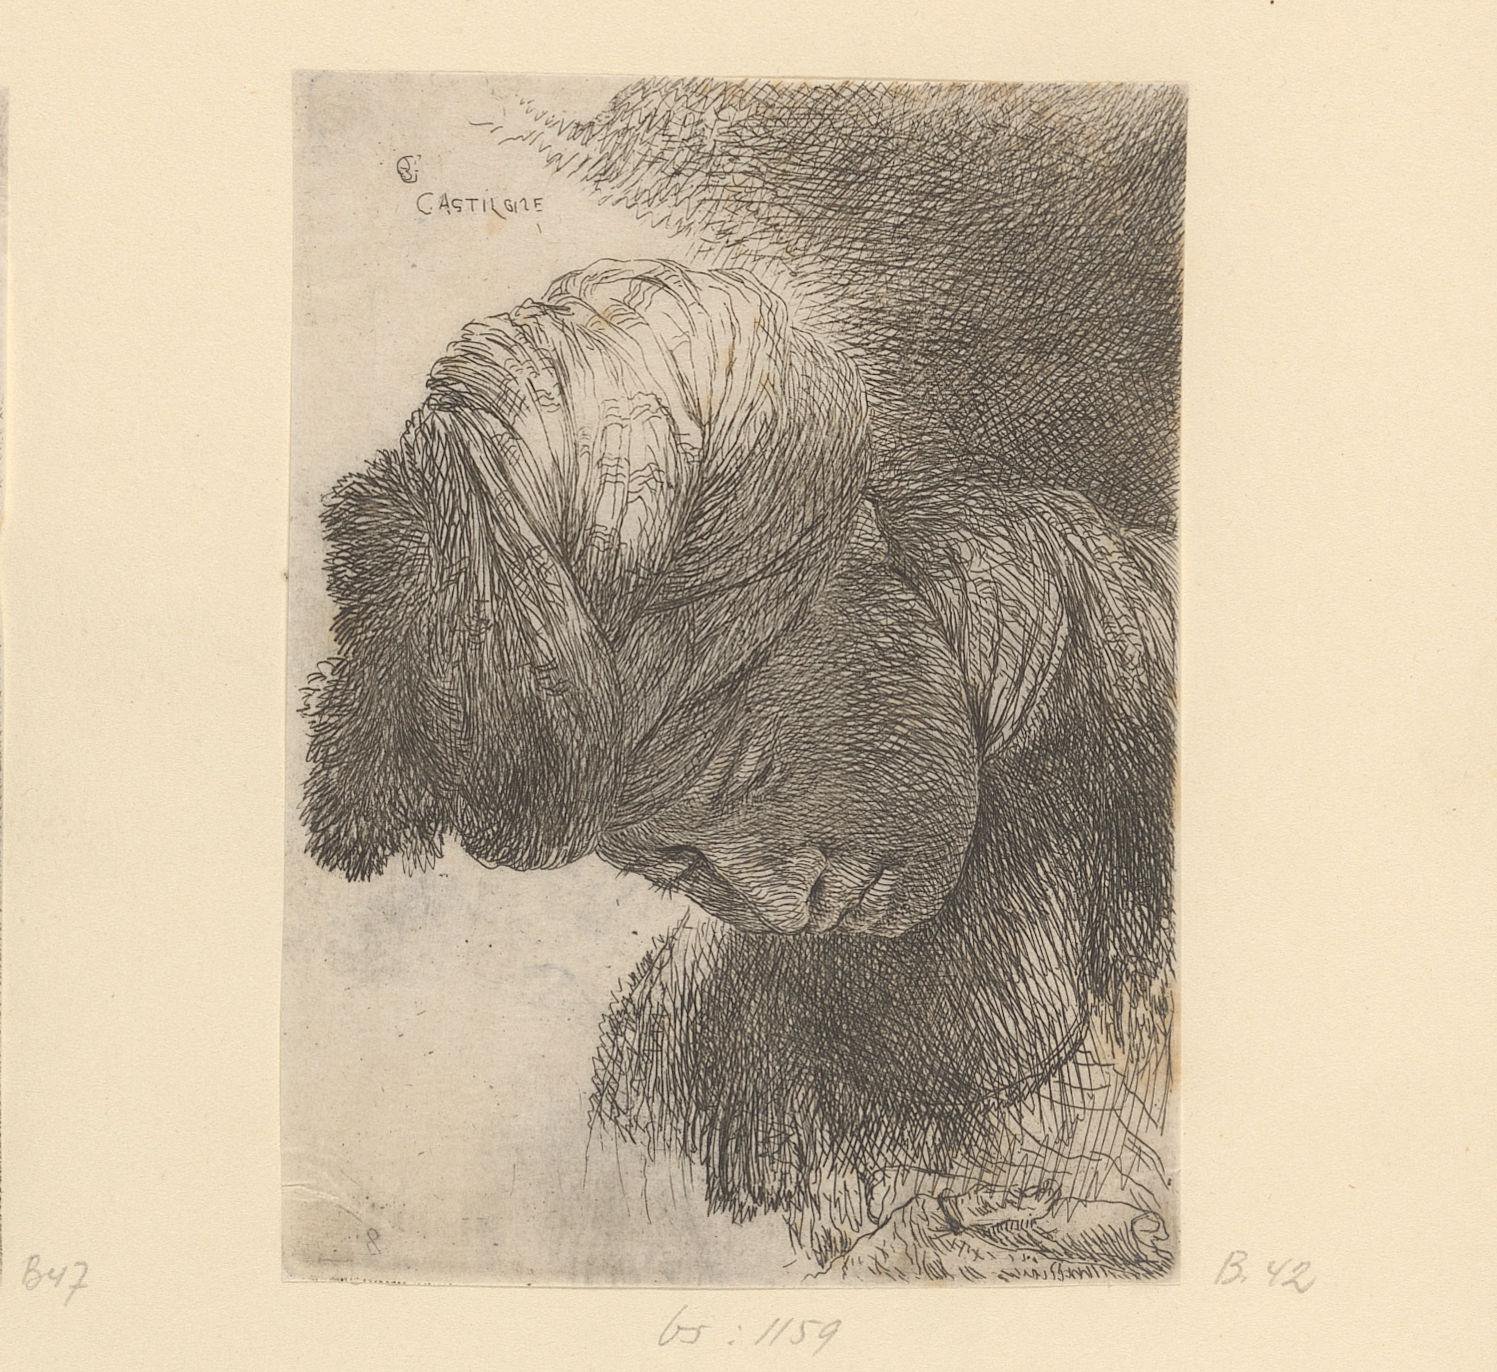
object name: album leaf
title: Hoofd van een jonge man met tulband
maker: giovanni benedetto castiglione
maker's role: draughtsman, print maker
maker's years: 1610-1665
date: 1645-1650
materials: paper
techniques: etching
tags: head (human), head-gear: turban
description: Prent is onderdeel van een serie van zestien prenten. Prent maakt mogelijk deel uit van een serie van 200 prenten. Deze serie is onder de titel 'A Collection of two hundred original etchings' voor het eerst uitgegeven door J.M. Greery in 1816.